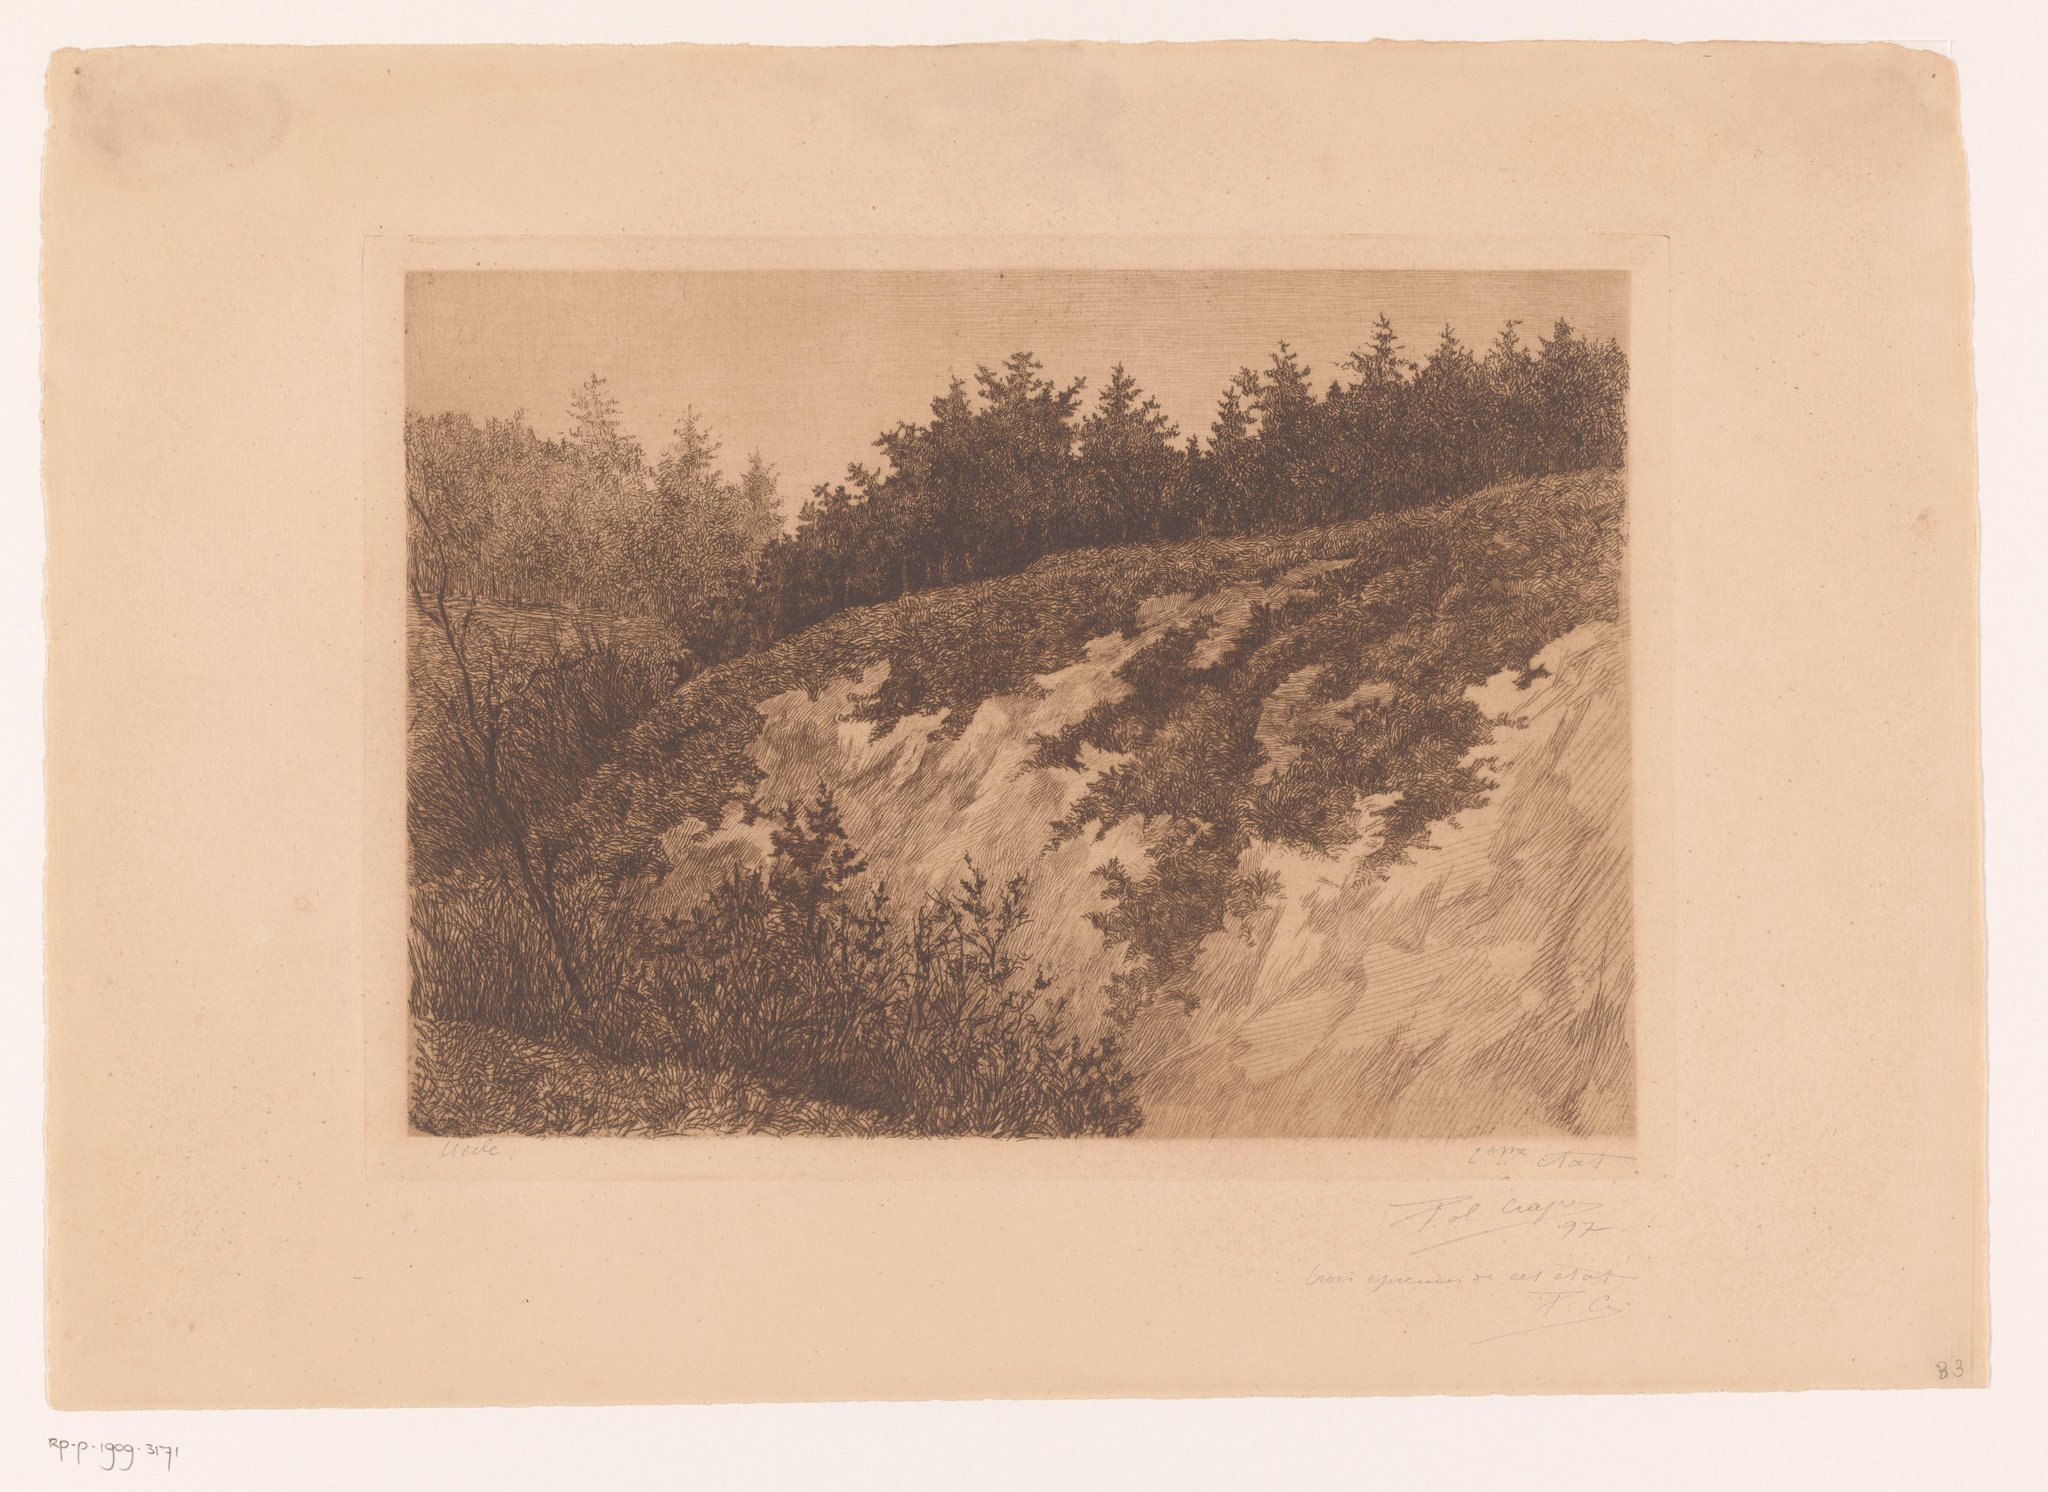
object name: print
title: Uccle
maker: pol craps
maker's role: print maker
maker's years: 1877-1939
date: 1897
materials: paper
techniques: drypoint, etching, intaglio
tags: landscapes in the temperate zone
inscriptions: annotation: ‘2eme etat; trois epreuves de cet etat’, collector's mark: Lugt 2228